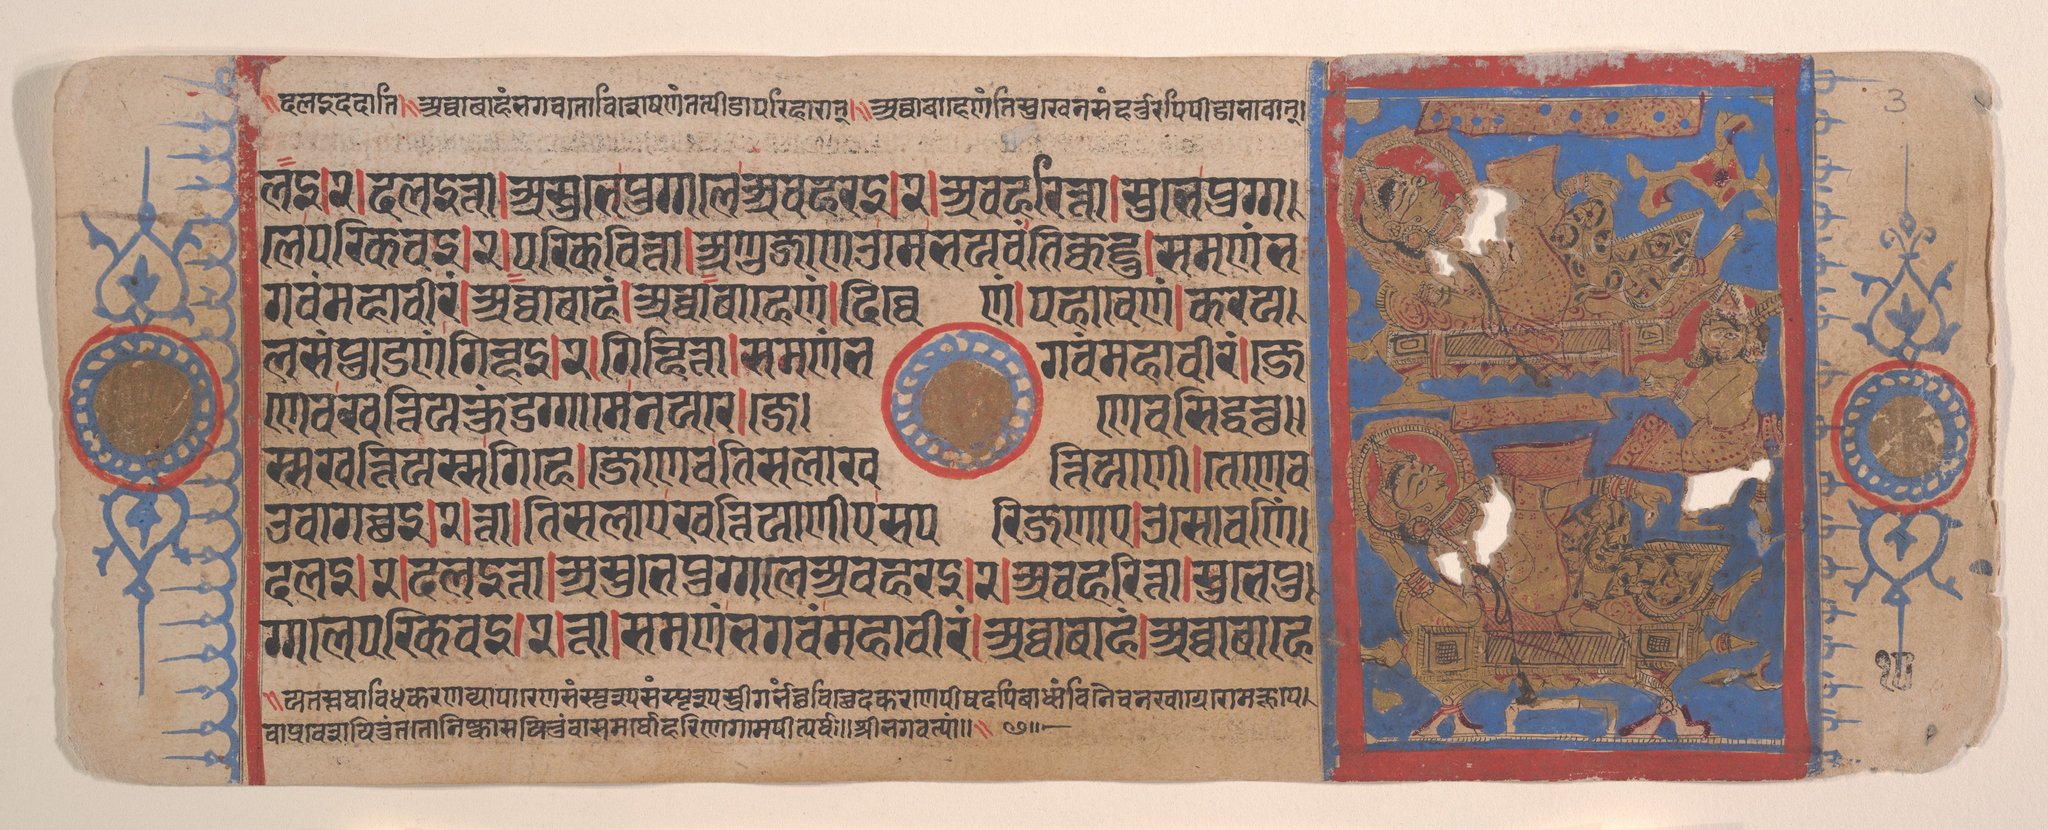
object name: folio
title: Leaf from a Kalpa Sutra (Jain Book of Rituals)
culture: indian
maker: bhadrabahu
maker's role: artist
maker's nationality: indian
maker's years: 356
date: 1401-1500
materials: gold, ink, paper, watercolor